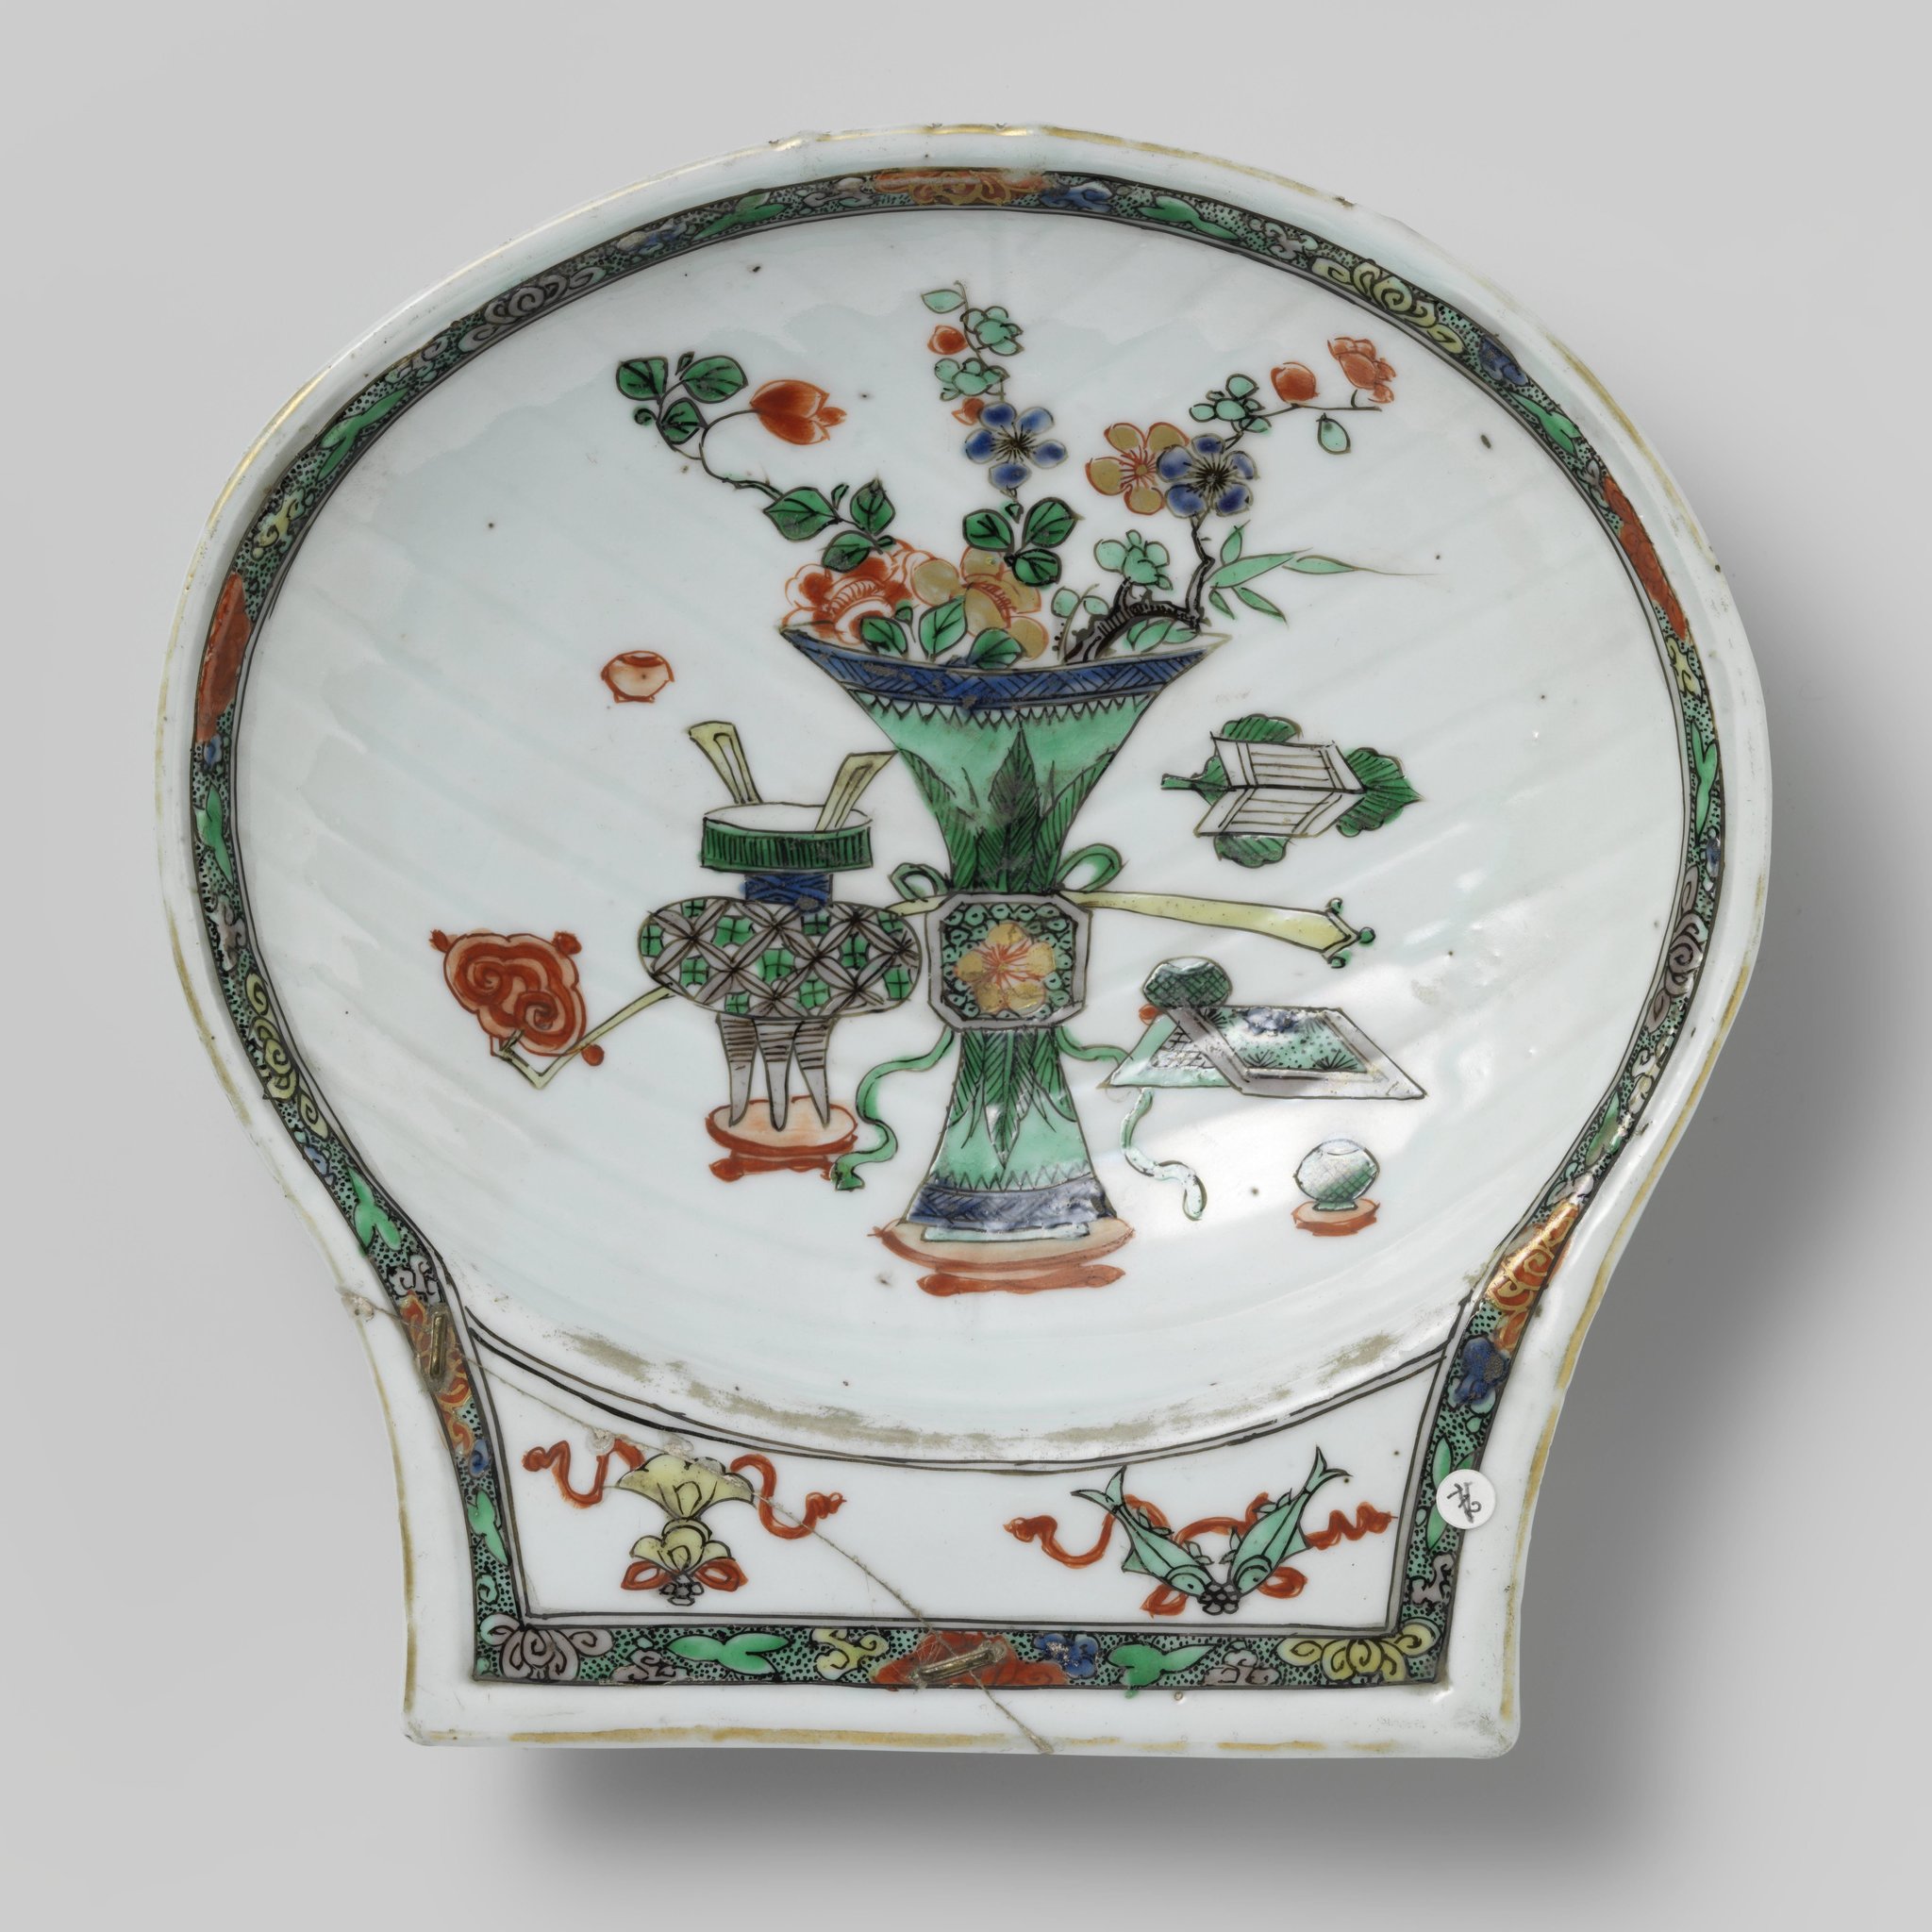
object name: bowl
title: Scallop-shell-shaped bowl with antiquities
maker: Anonymous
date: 1700-1724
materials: cobalt, glaze, gold, paint, porcelain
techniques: firing, forming, gilding, vitrification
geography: china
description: Schelpvormige schotel in 'famille verte'. Beschilderd met een vaas met bloemen en emblemen. Er zit 1 grote, gekramde barst in.